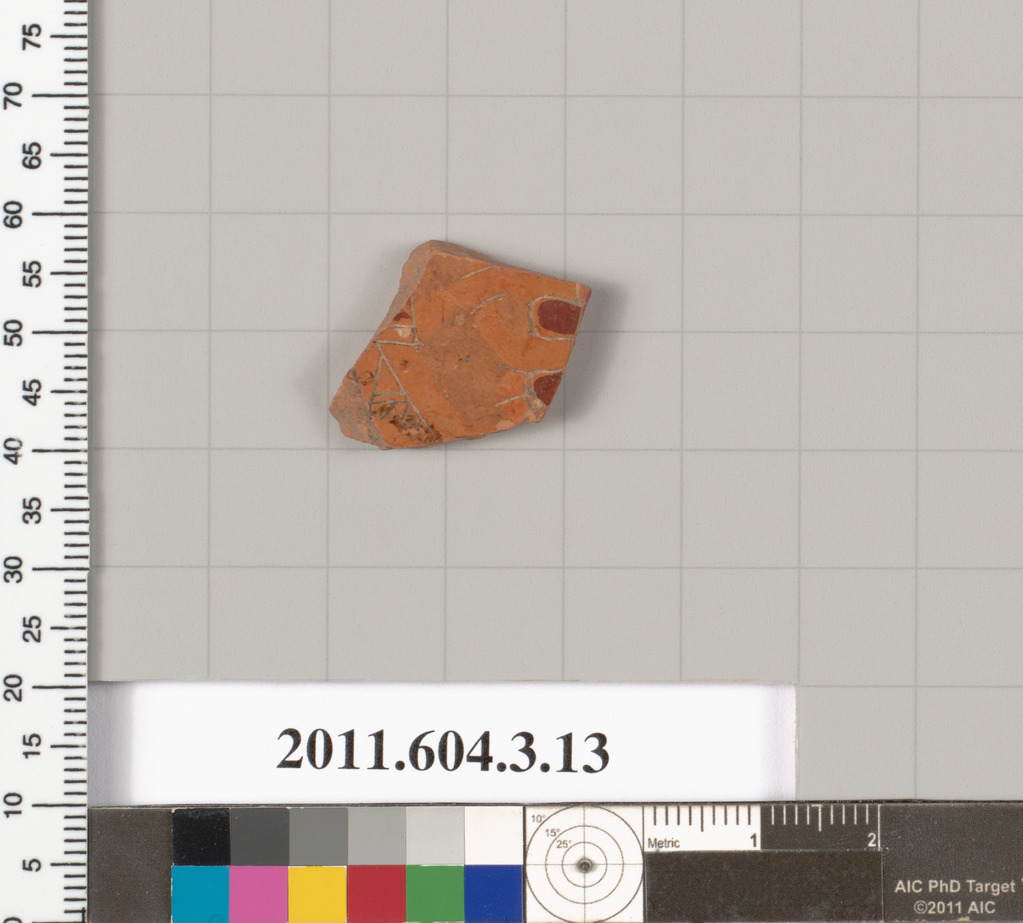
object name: undetermined closed shape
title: Terracotta fragment of a closed shape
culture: greek, attic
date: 600-501 BCE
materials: terracotta